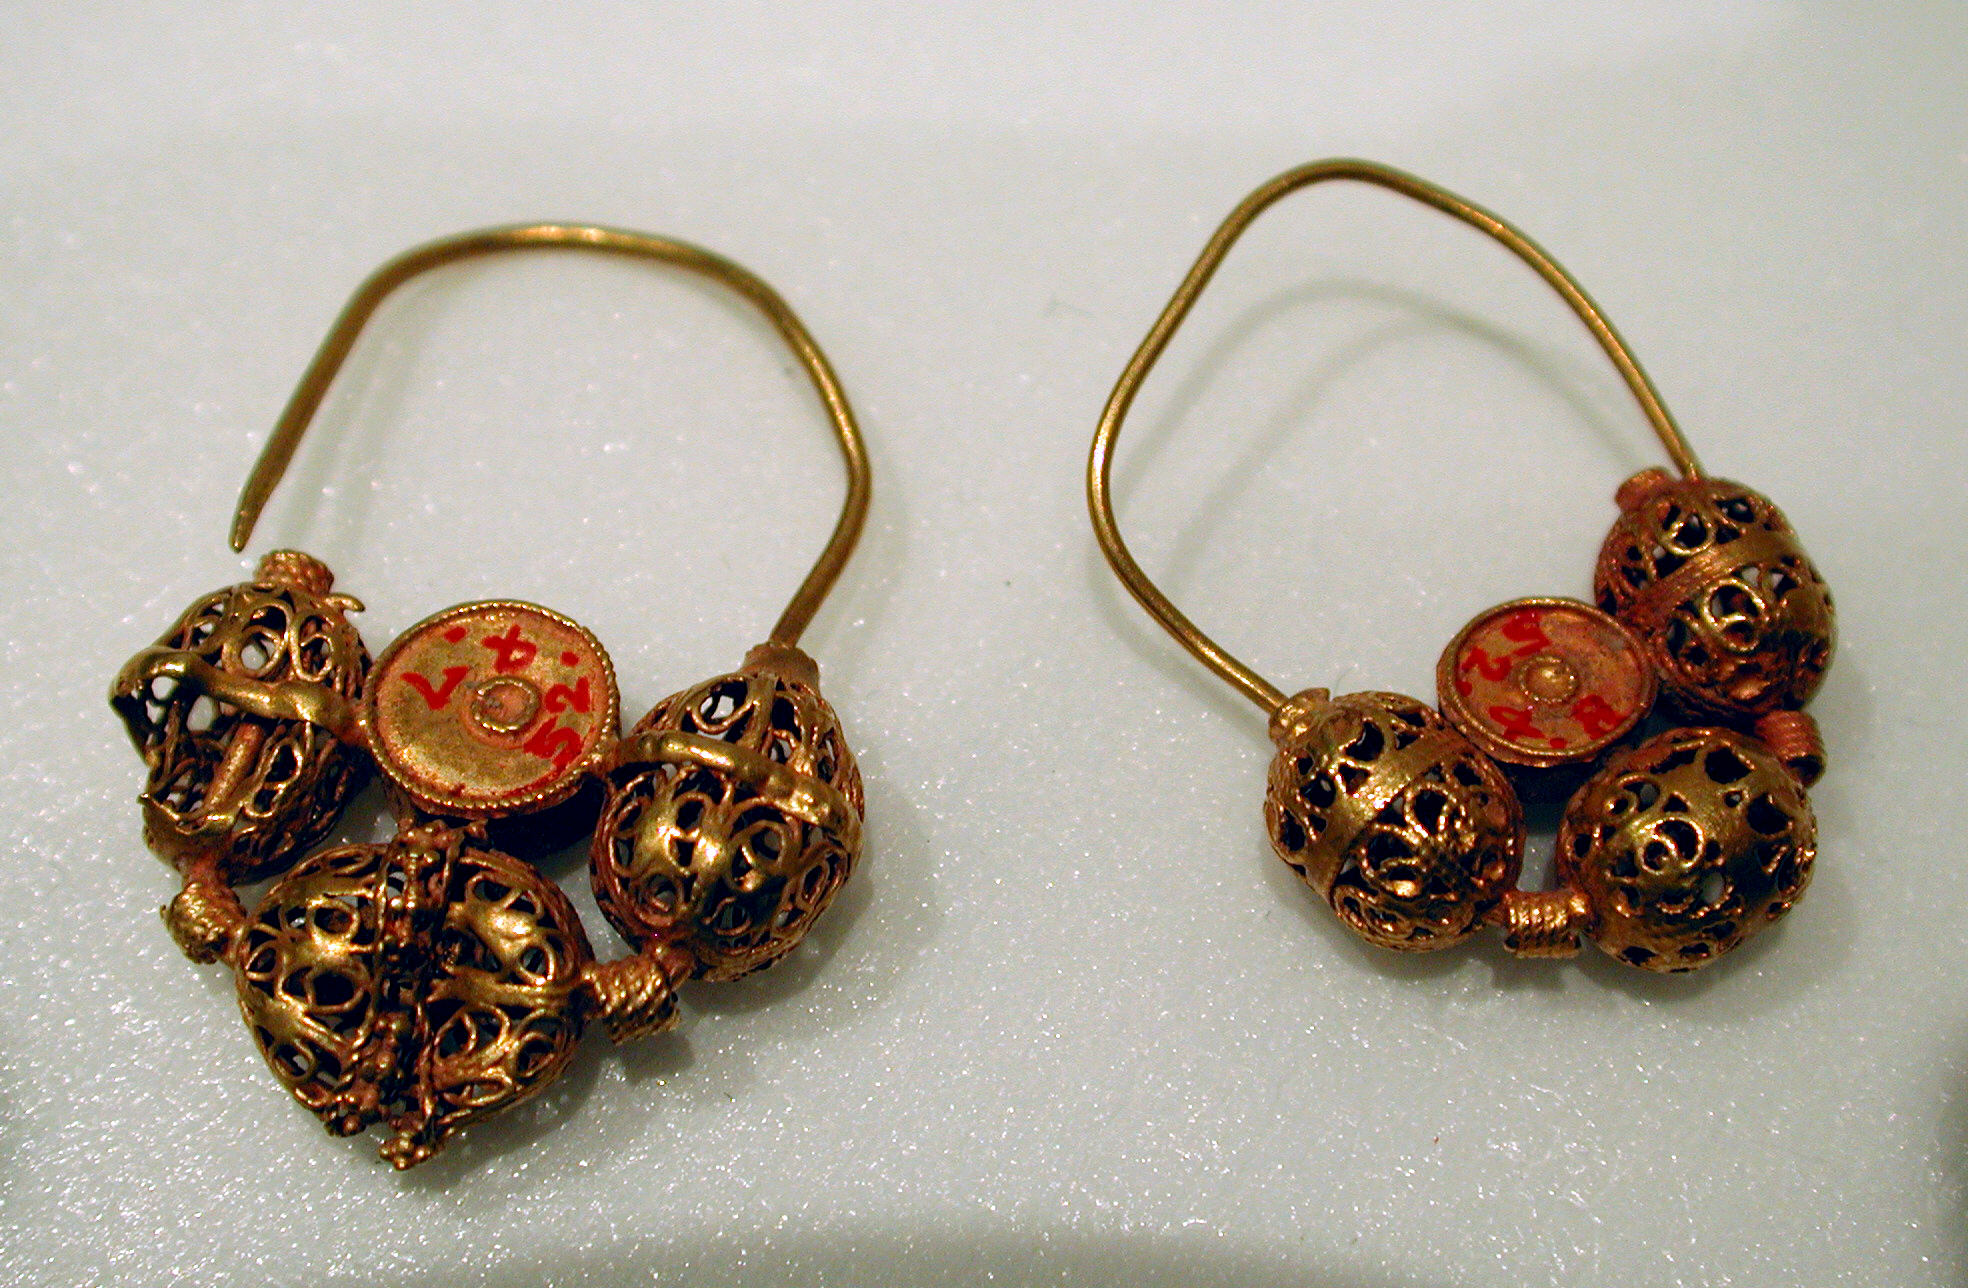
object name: earring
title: Earring, One of a Pair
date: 1101-1300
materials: gold, metal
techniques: filigree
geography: iran